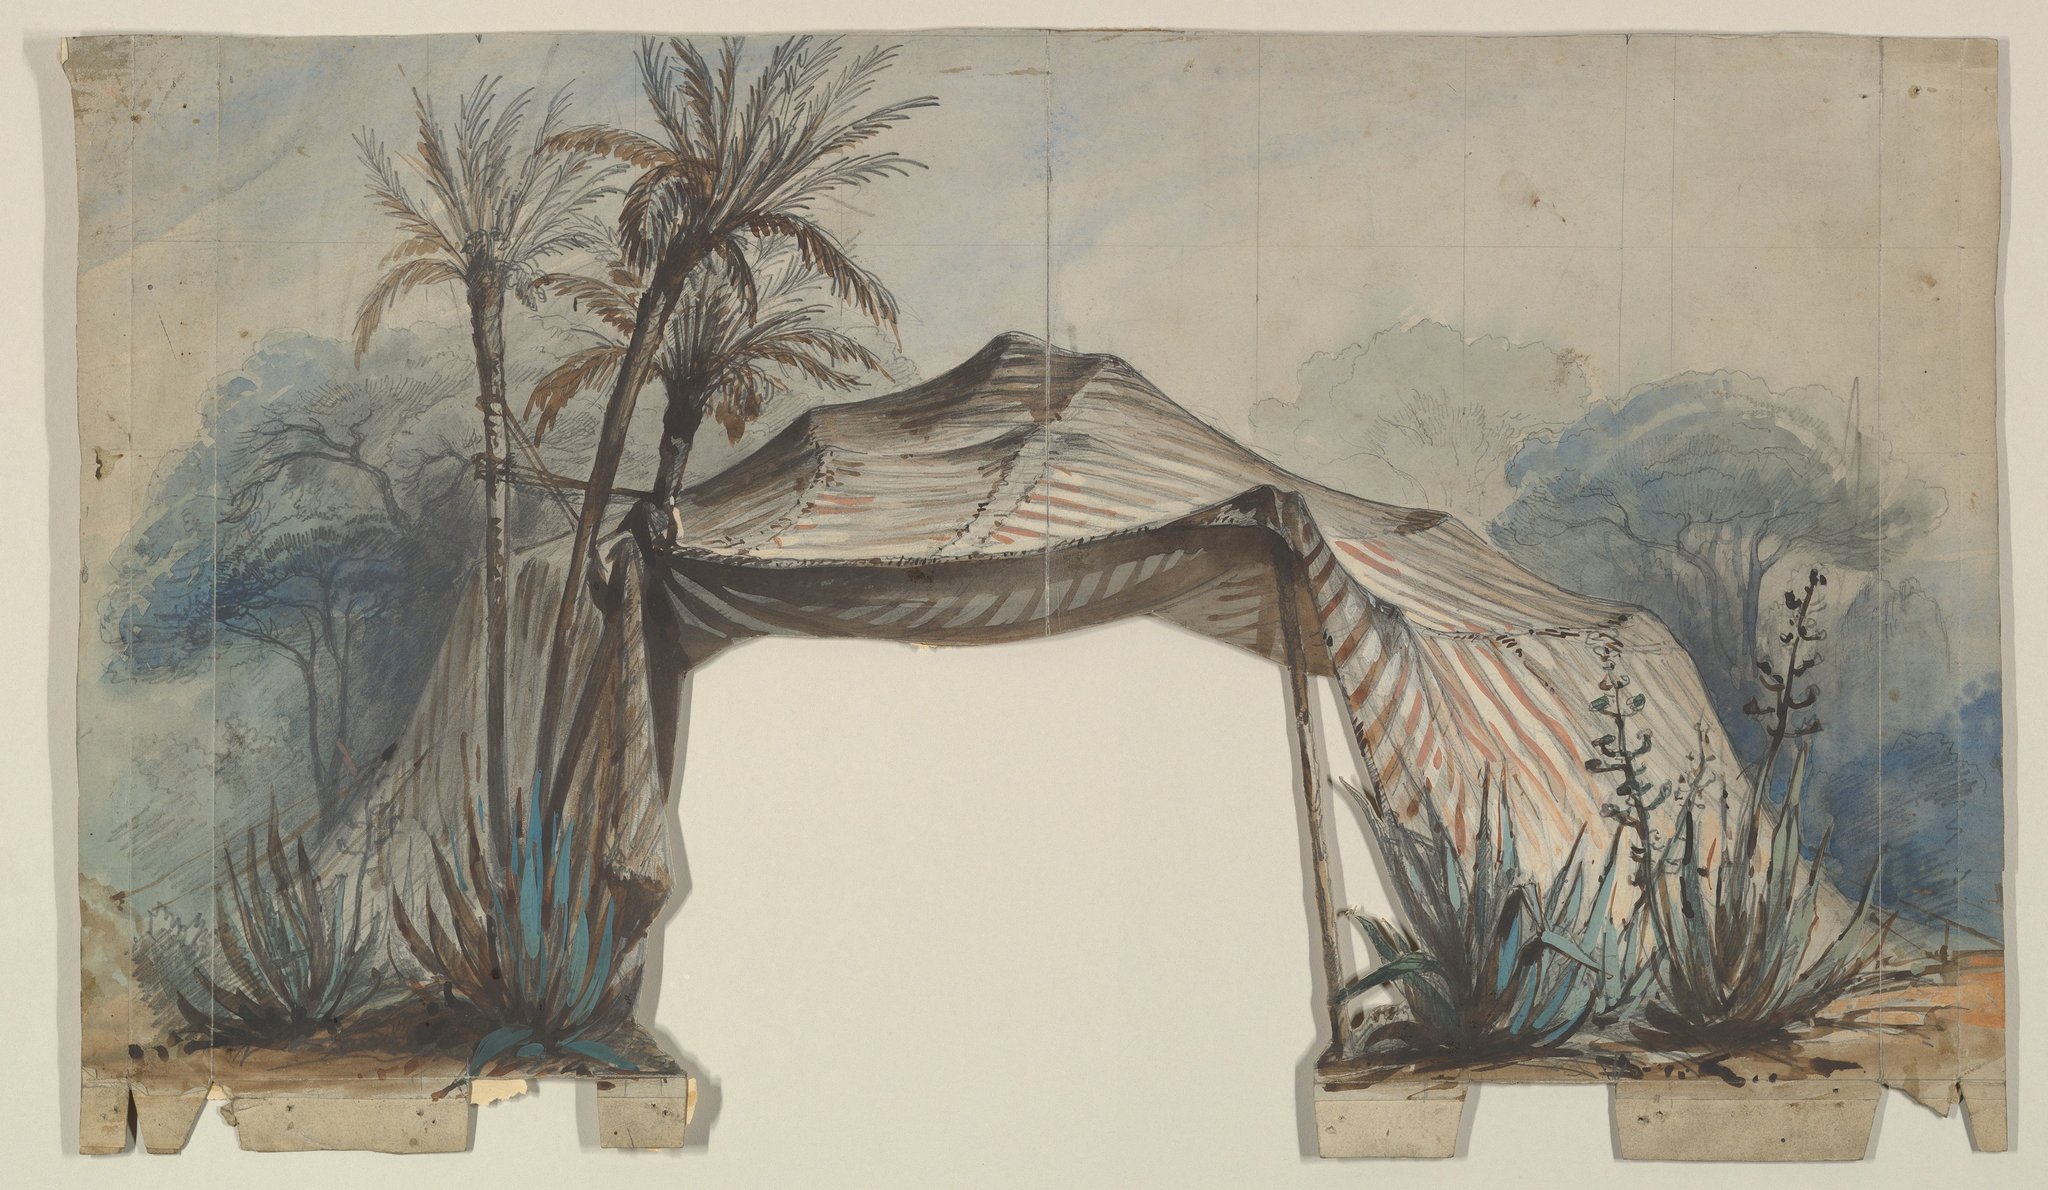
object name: drawing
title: Design for a Stage Set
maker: eugène cicéri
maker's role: artist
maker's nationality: french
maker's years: 1813-1890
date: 1830-1890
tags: tents,trees,stage design